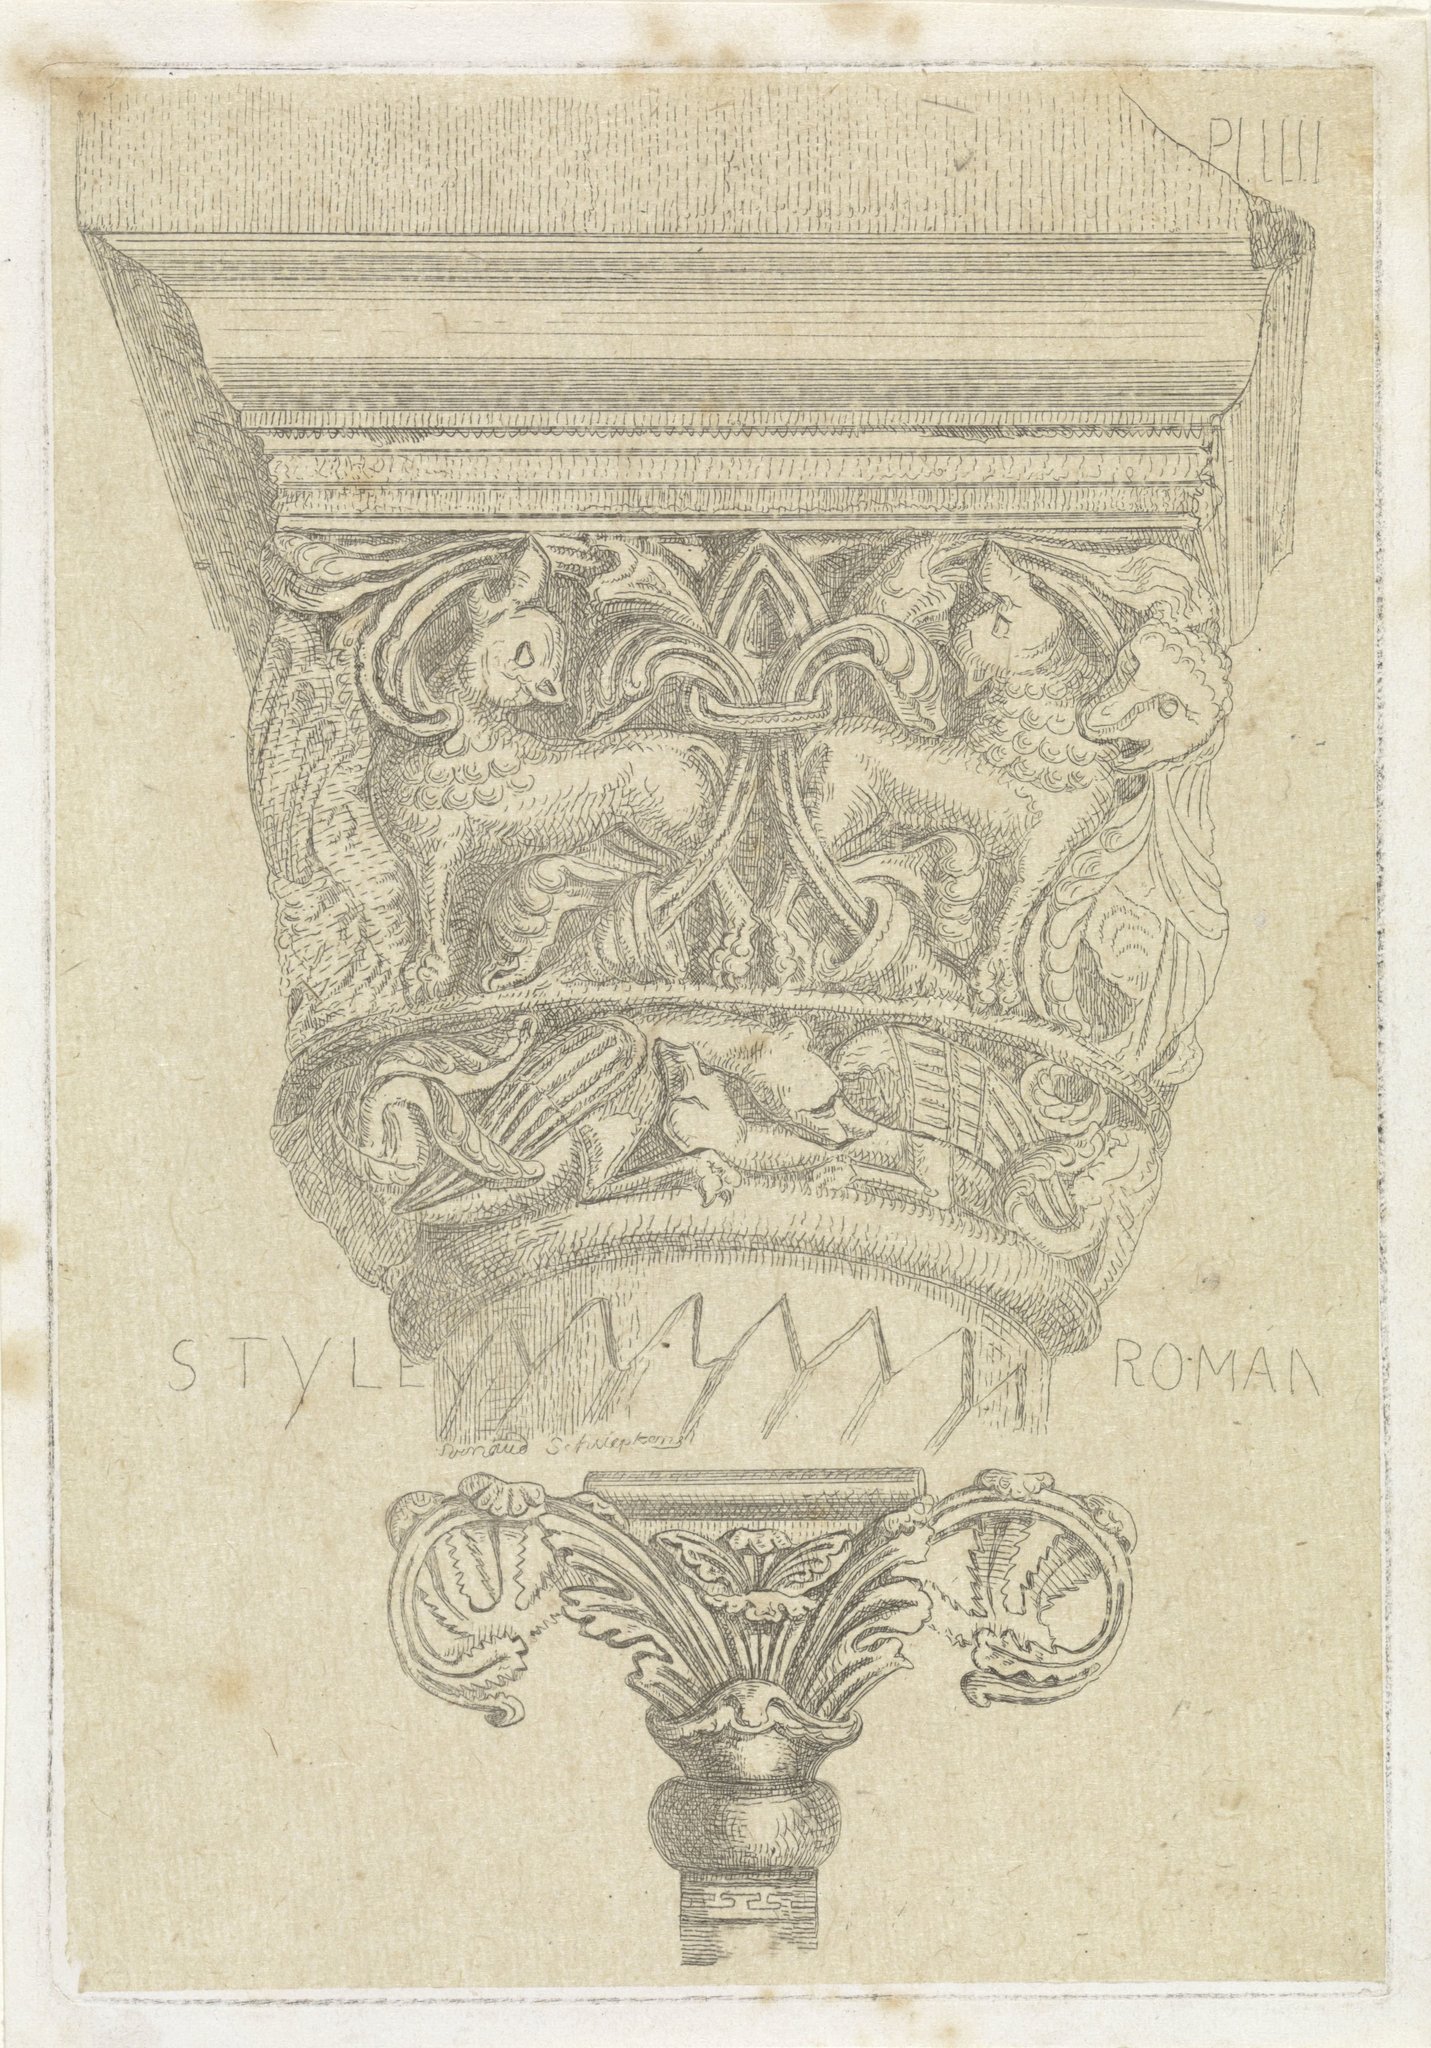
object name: print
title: Romaans kapiteel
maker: arnoud schaepkens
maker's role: print maker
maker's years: 1816-1904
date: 1831-1904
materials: paper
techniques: etching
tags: capital (~ column, pillar)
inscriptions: collector's mark: Lugt 2228